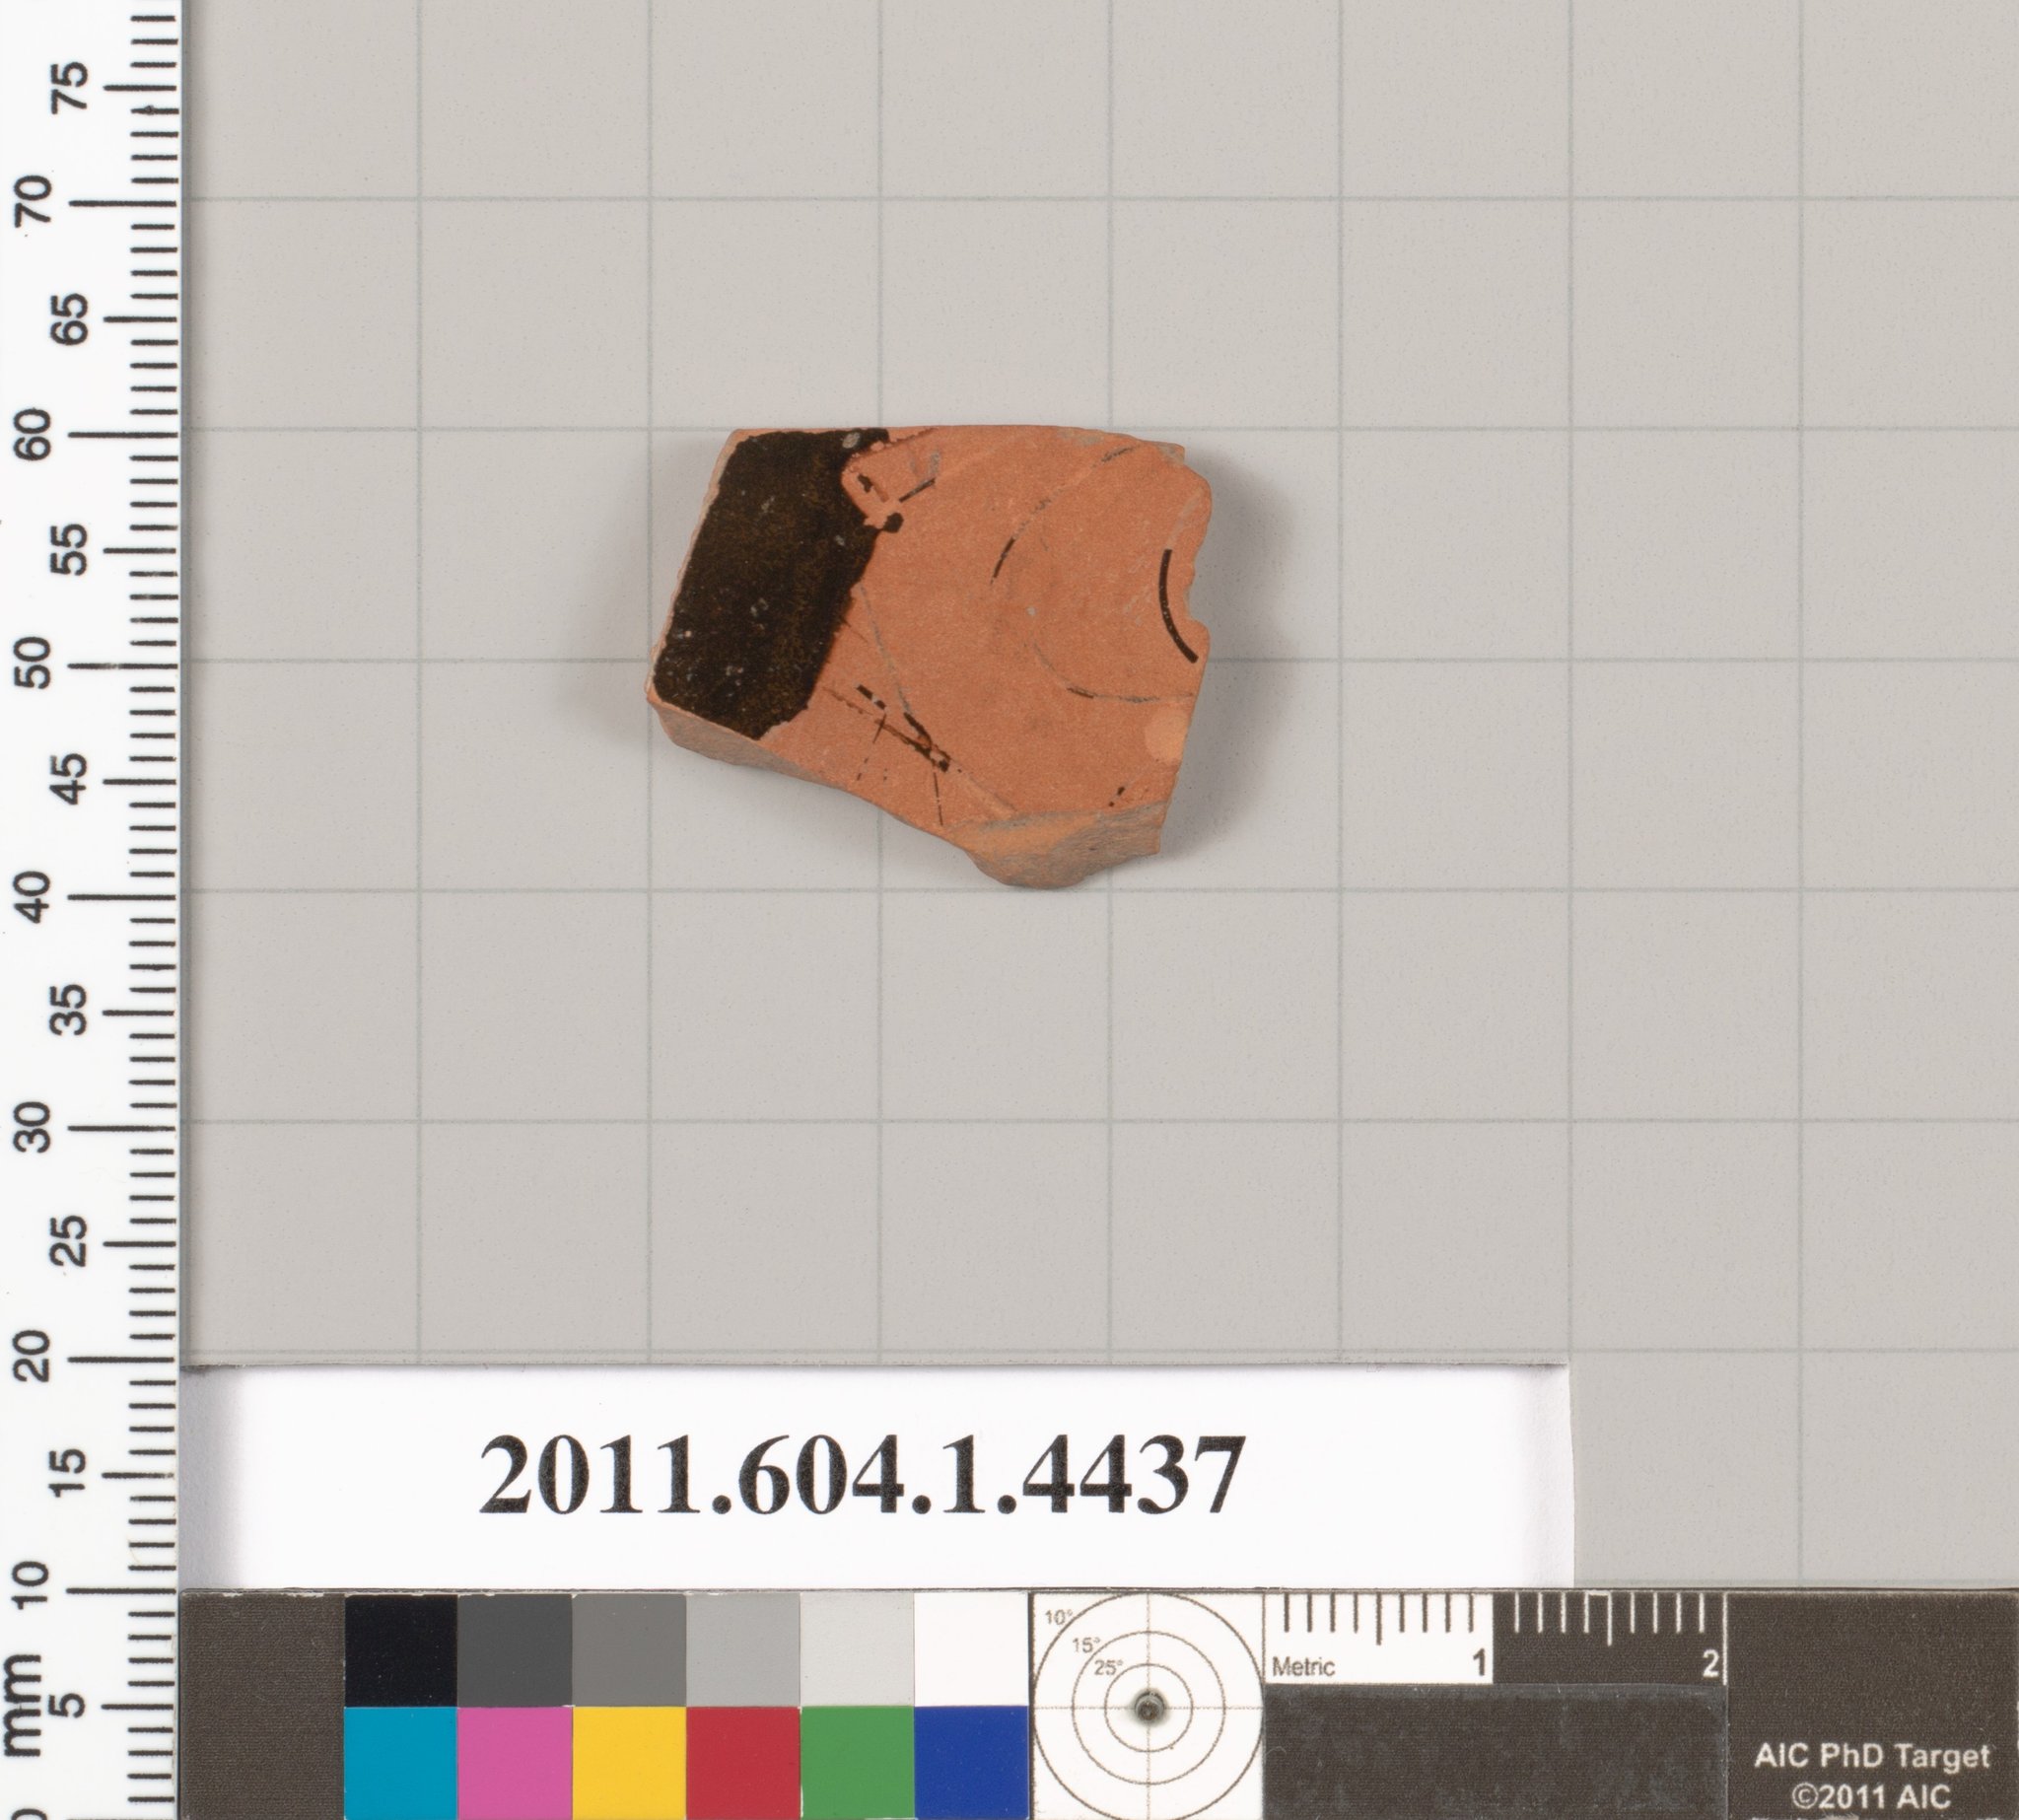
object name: kylix fragment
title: Terracotta fragment of a kylix (drinking cup)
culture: greek, attic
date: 475-451 BCE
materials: terracotta